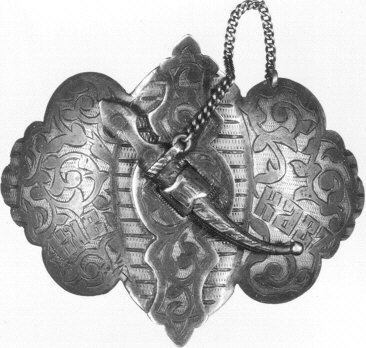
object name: belt buckle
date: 1834-1866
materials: niello, silver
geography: caucasus